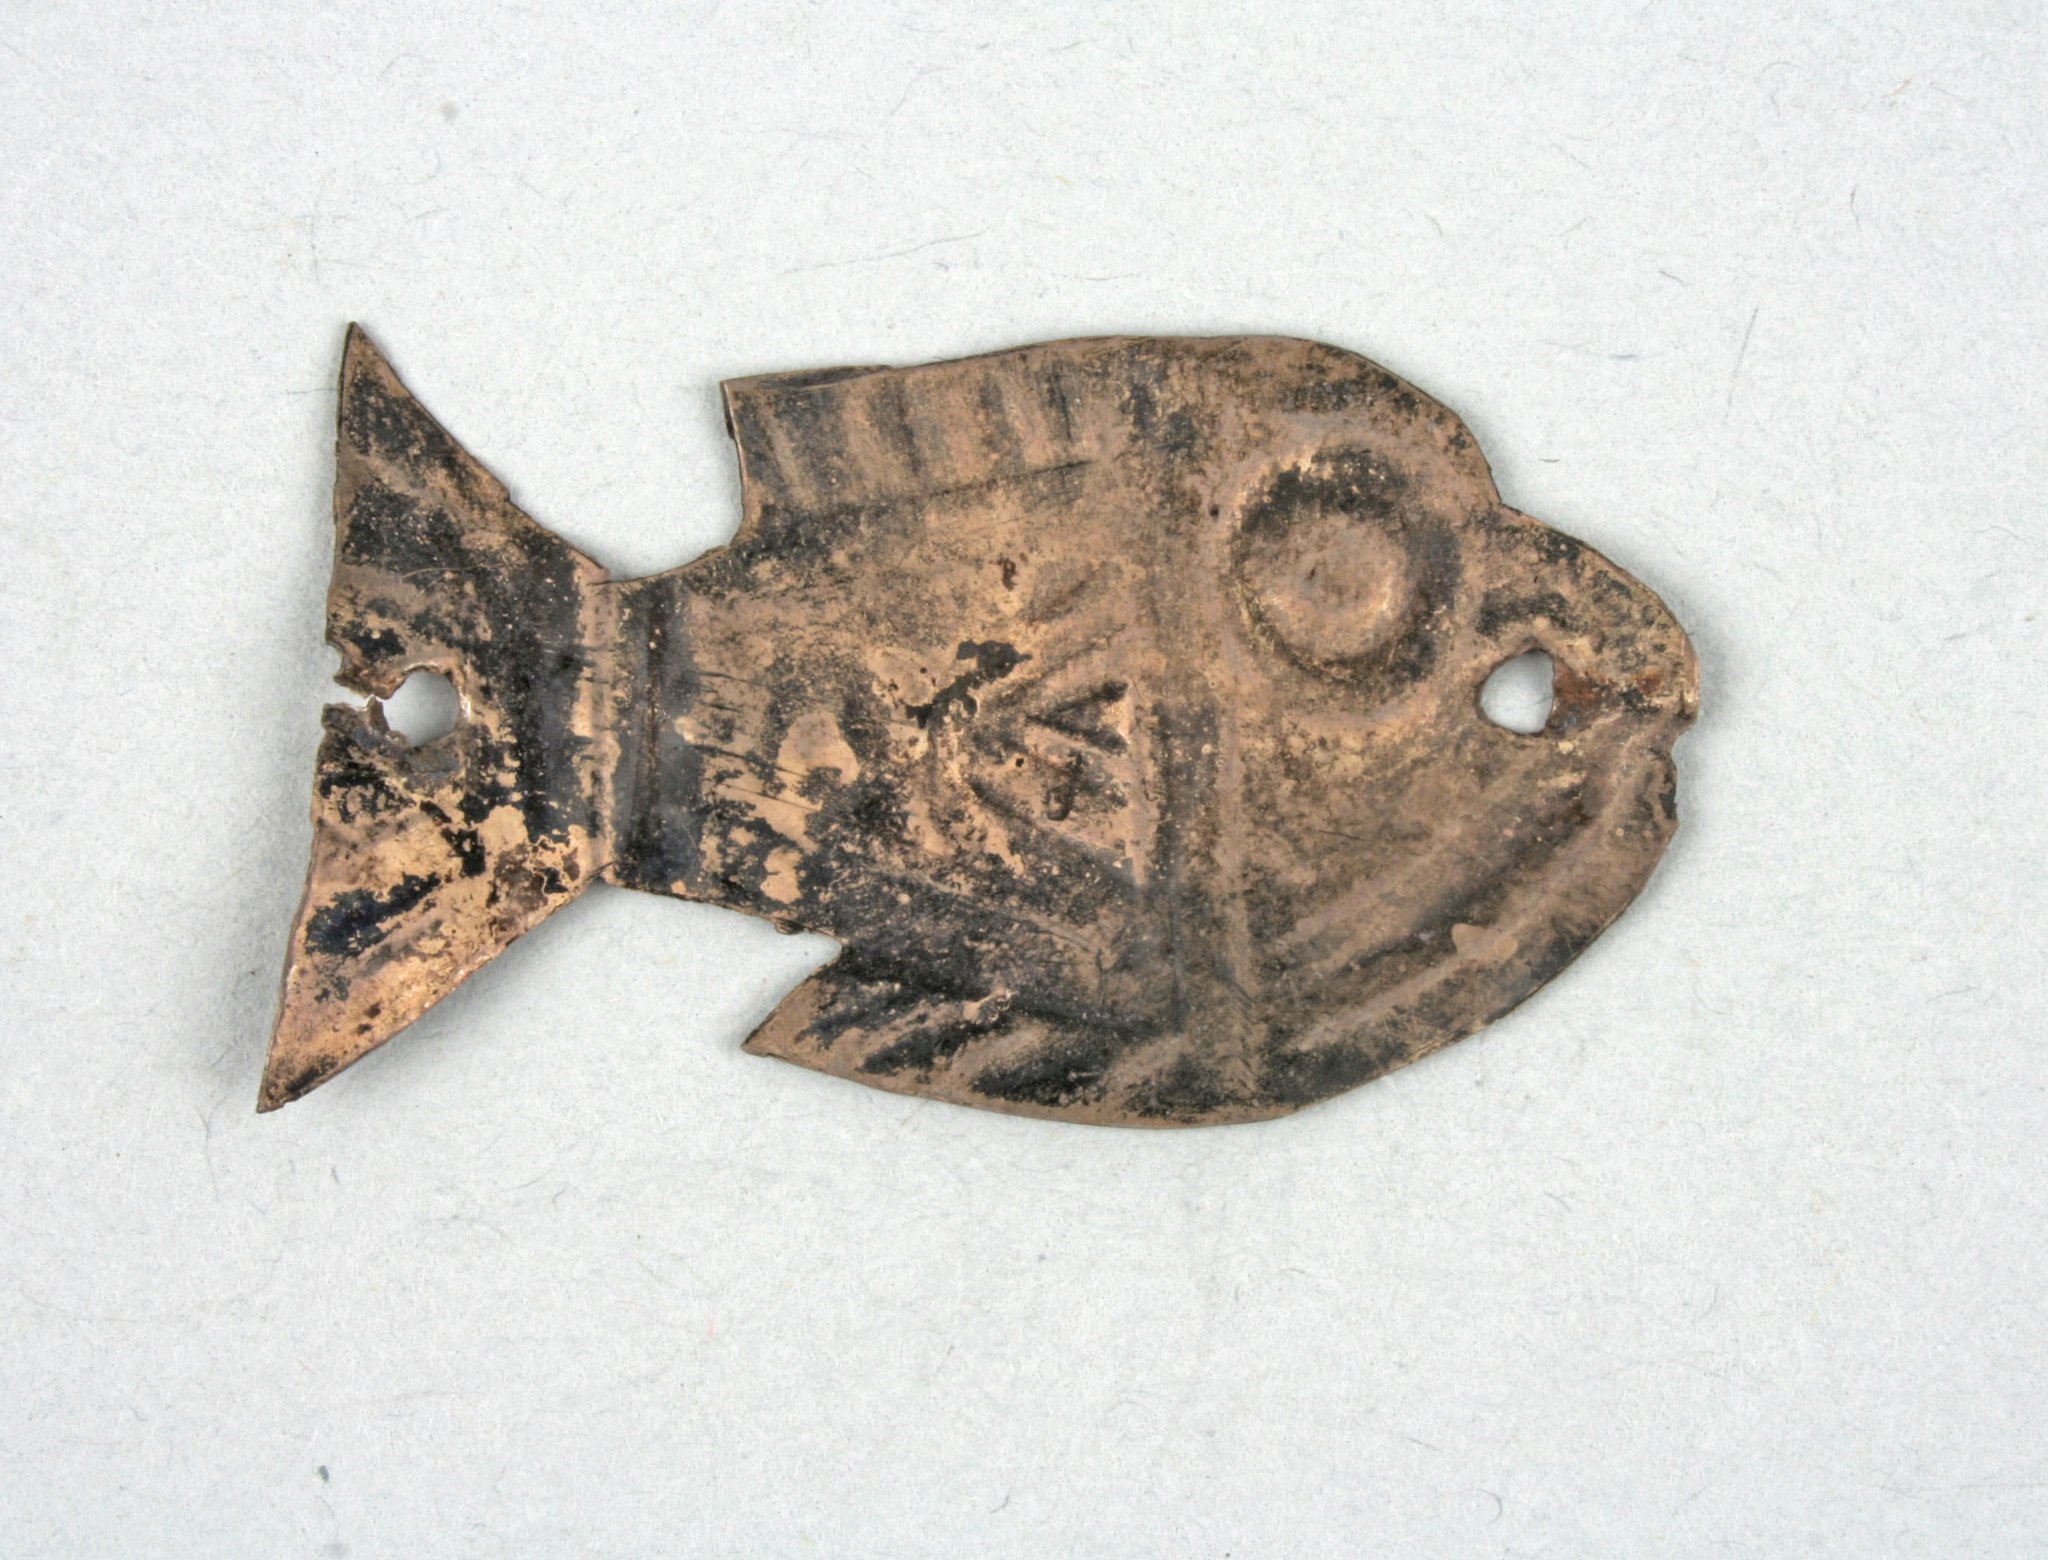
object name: costume ornament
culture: central coast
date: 1001-1200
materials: silver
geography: peru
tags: fish